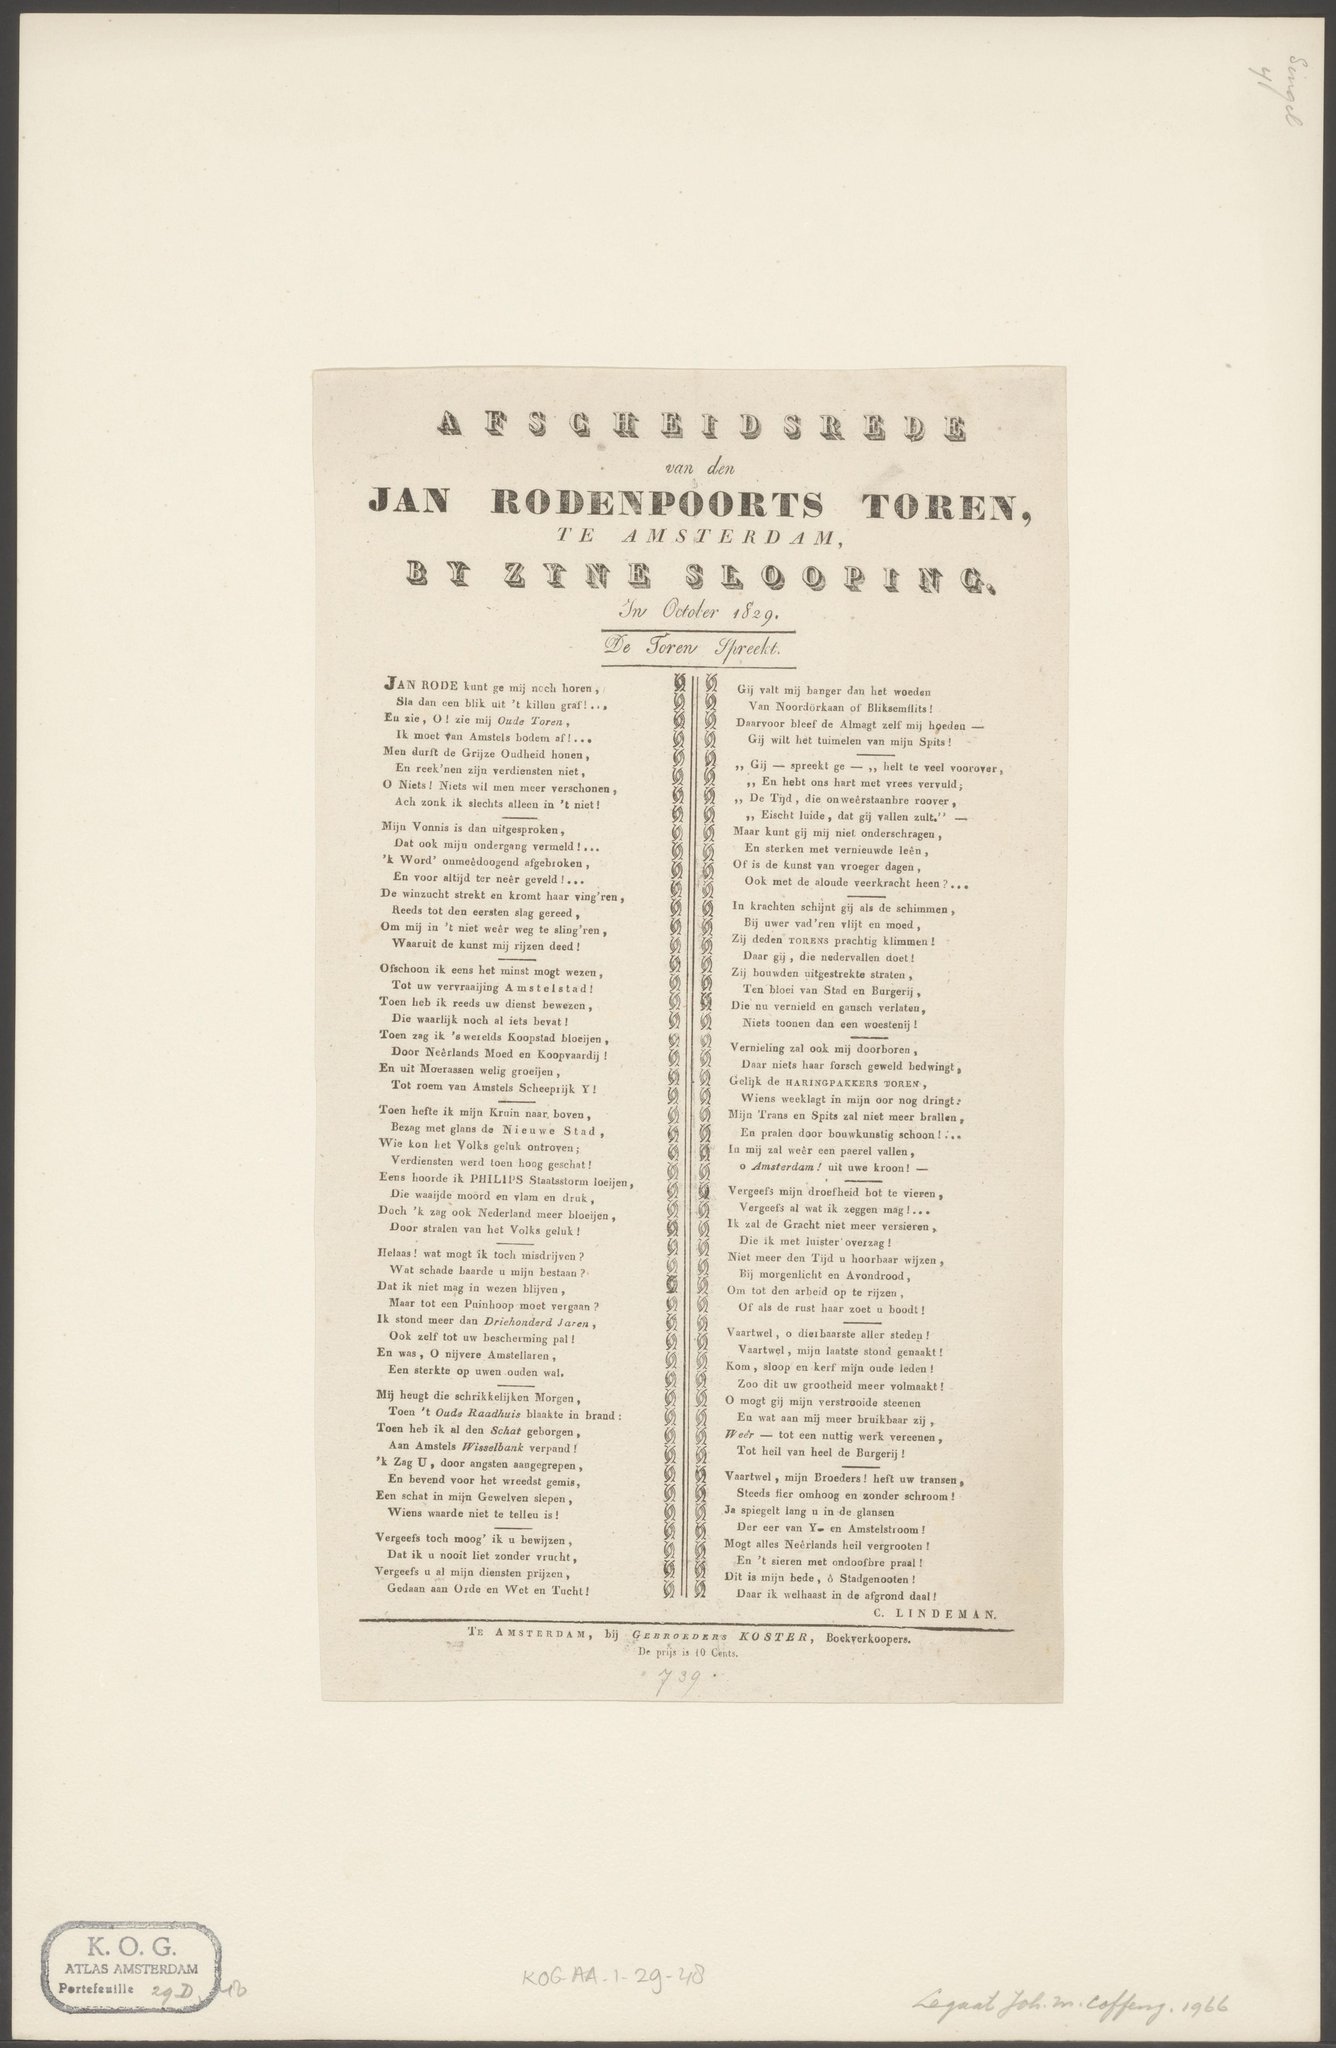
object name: text sheet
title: Afscheidsrede van den Jan Rodenpoorts Toren, te Amsterdam, by zyne slooping, in October 1829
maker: cornelis lindeman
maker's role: dichter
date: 1829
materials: paper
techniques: letterpress printing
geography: amsterdam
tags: tower, clock tower ~ monumental adornment, demolition of building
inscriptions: collector's mark: Lugt 1641b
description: Onderwerpsrubriek binnen de Atlas Amsterdam: Jan Roodenpoortstoren.